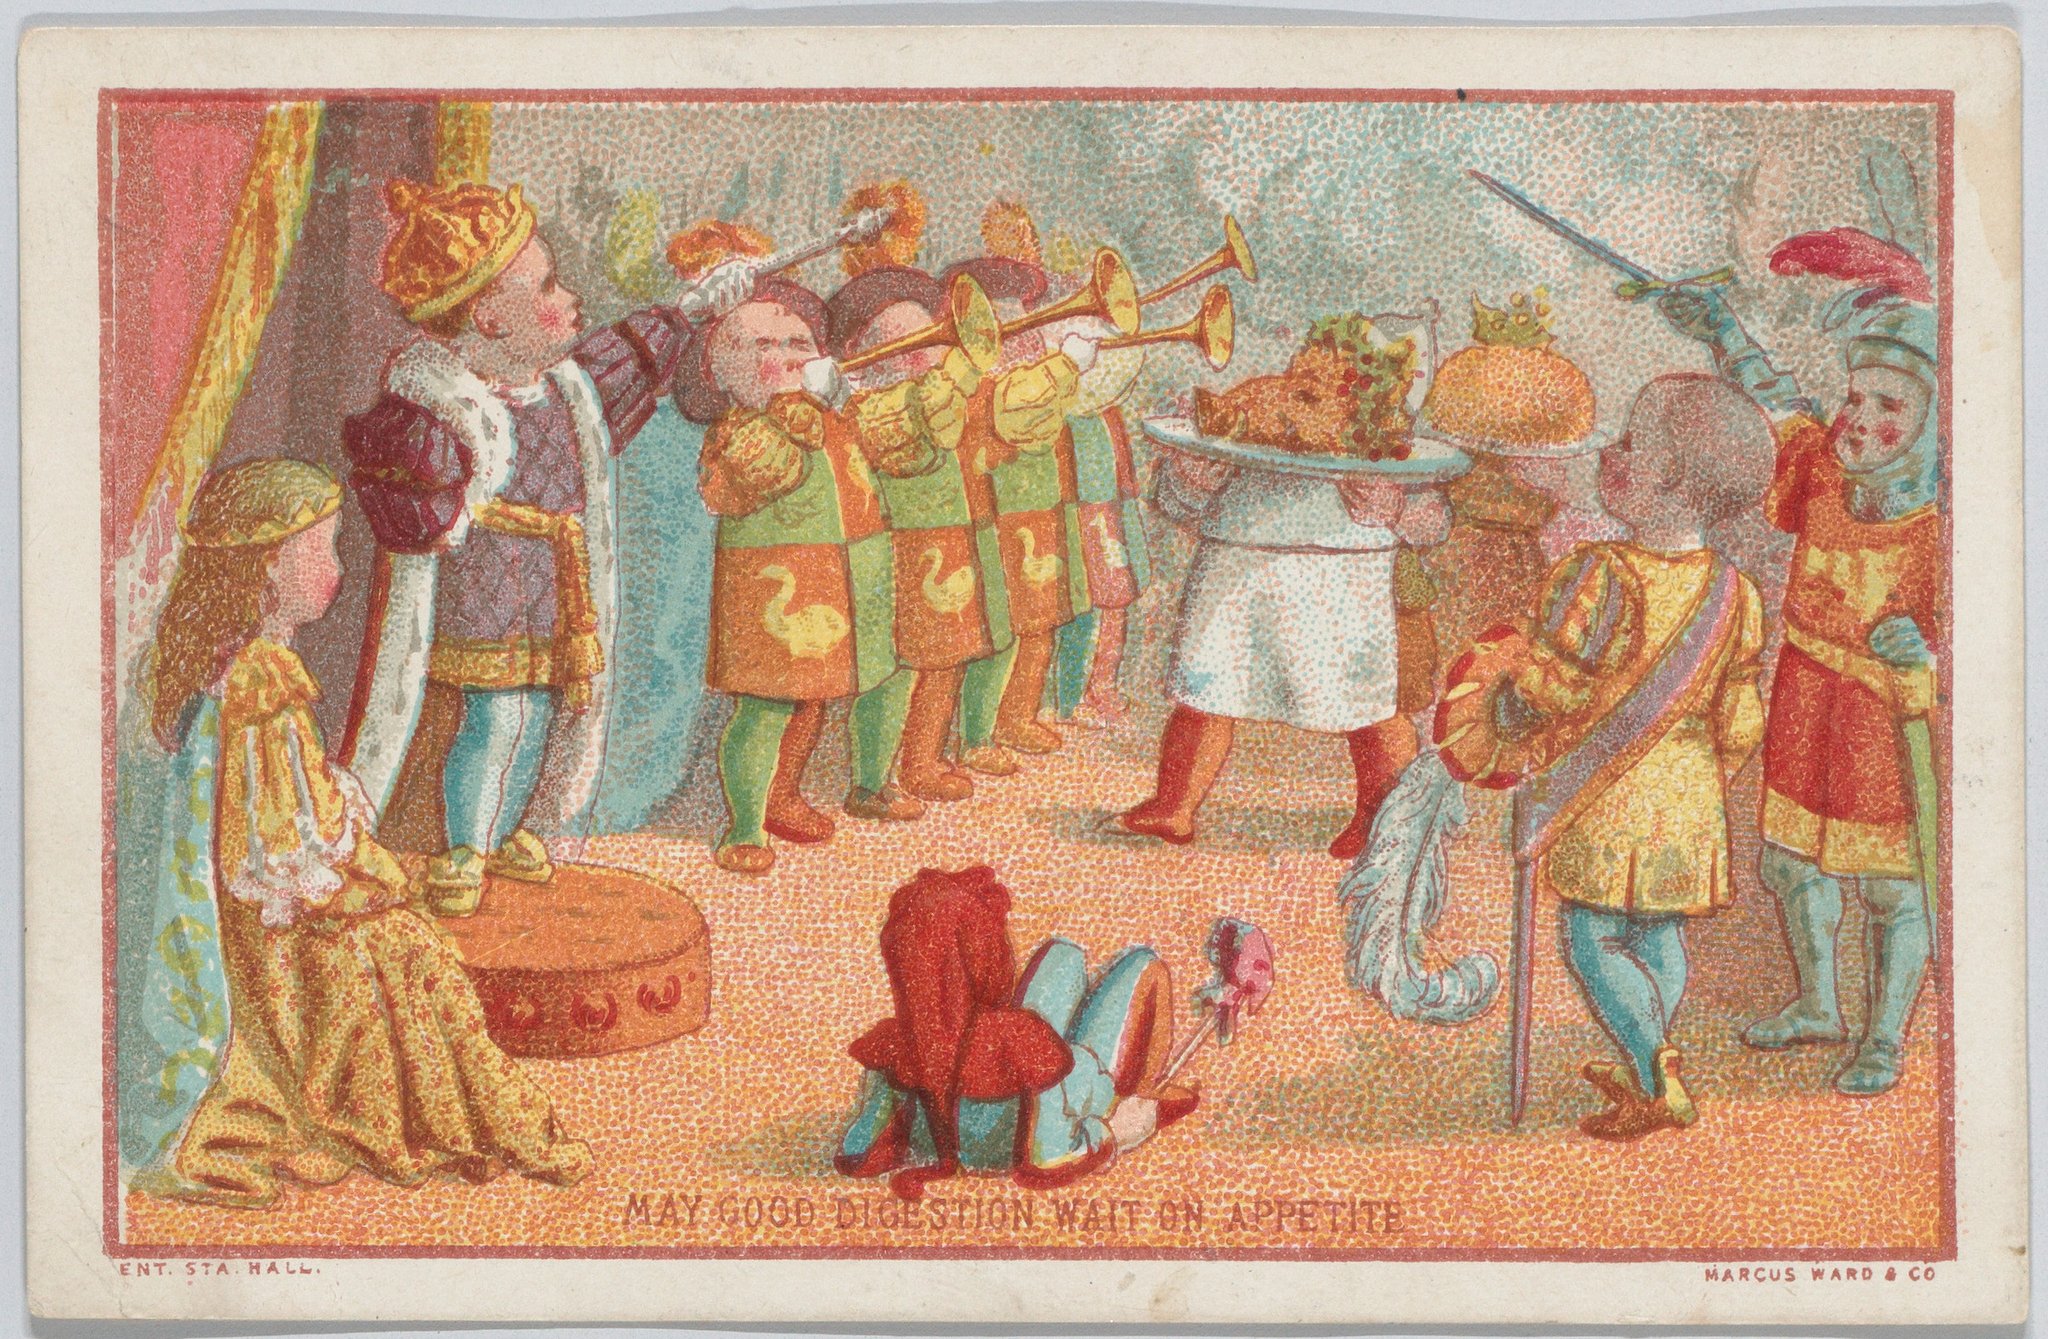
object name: valentine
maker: Anonymous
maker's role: artist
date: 1874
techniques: chromolithography